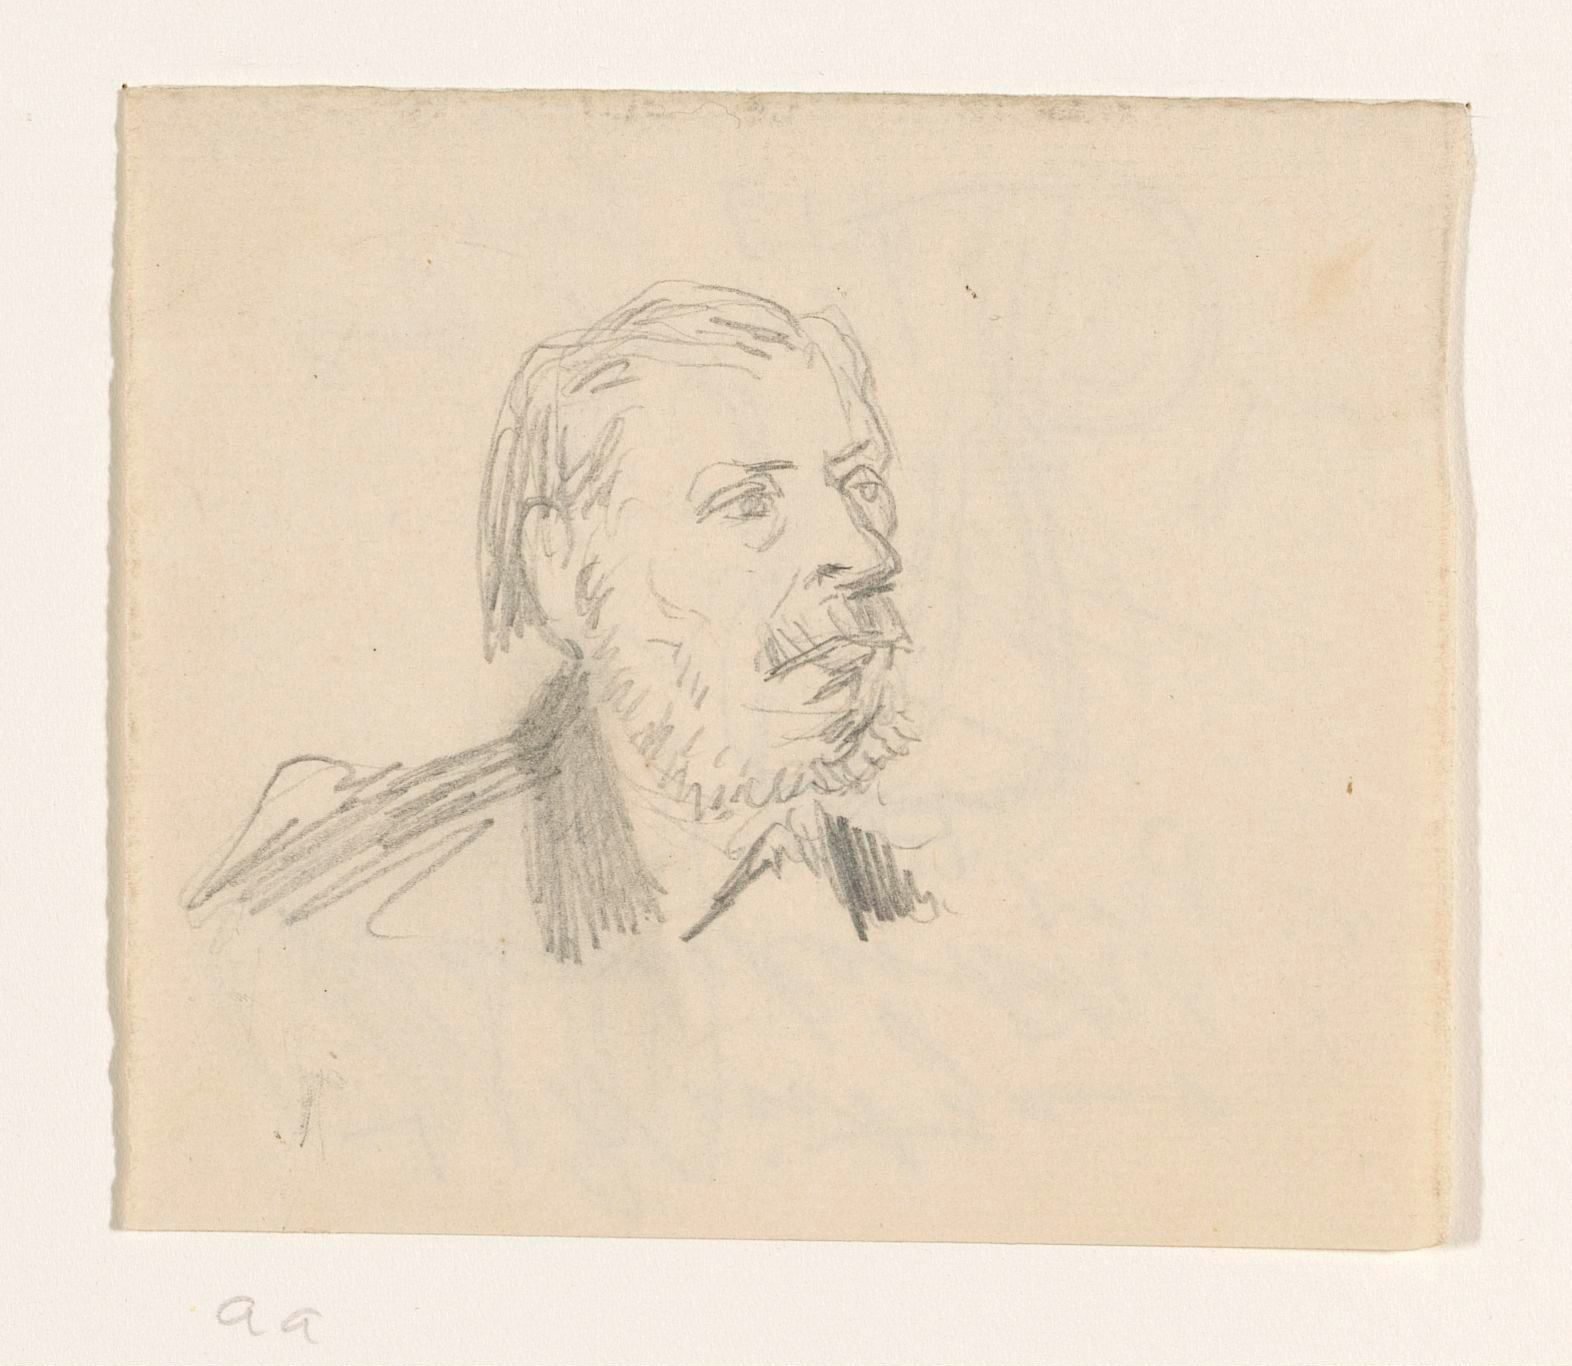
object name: cartoon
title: Portretschets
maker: johan michaël schmidt crans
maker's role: draughtsman, print maker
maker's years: 1830-1907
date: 1875-1895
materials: paper, pencil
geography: netherlands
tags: historical persons not known by name, netherlands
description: Schetsblad met een portret van een onbekende man, mogelijk een kamerlid. Mogelijk een voorstudie voor een politieke spotprent. Op de verso potloodkrabbels.